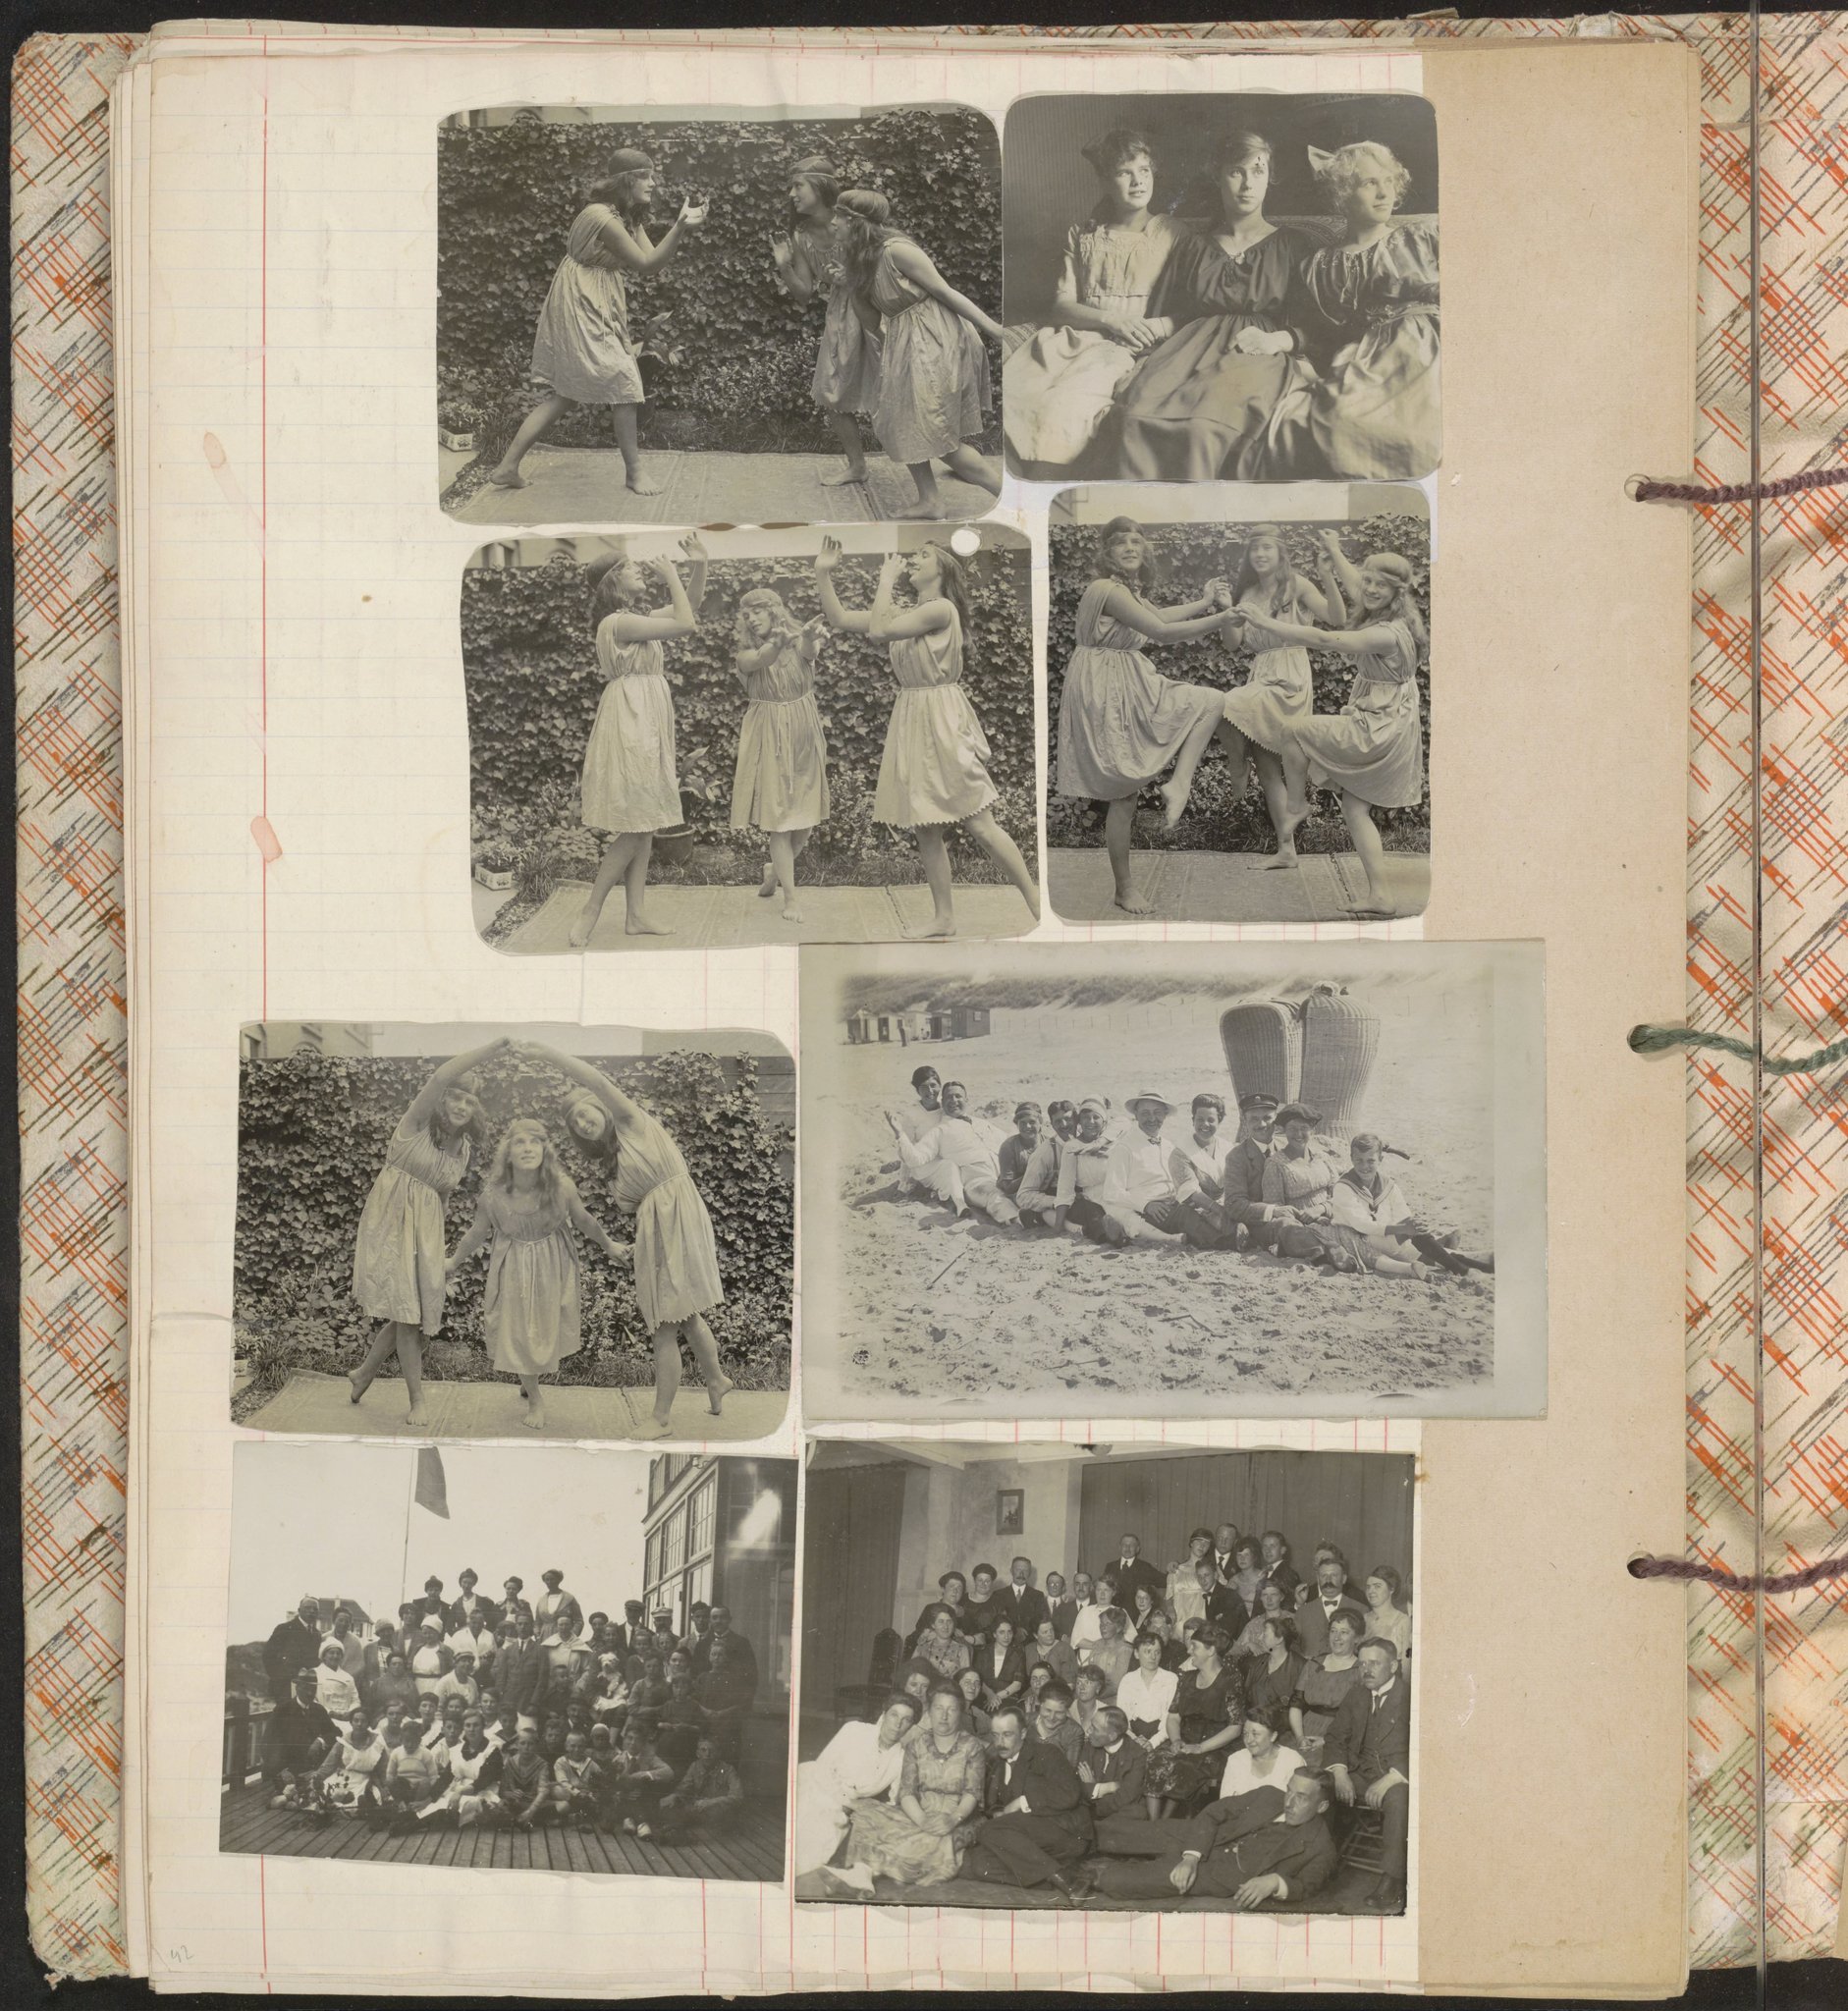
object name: photograph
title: Portretten van onbekende personen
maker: Anonymous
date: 1910-1930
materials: paper, photographic support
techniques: gelatin silver print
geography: netherlands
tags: adult woman, dancing, adult man, child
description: Albumblad met portretten van dansende meisjes en groepsfoto's van gezelschappen aan zee en in een zaal. Onderdeel van Fotoalbum van de familie Petri.